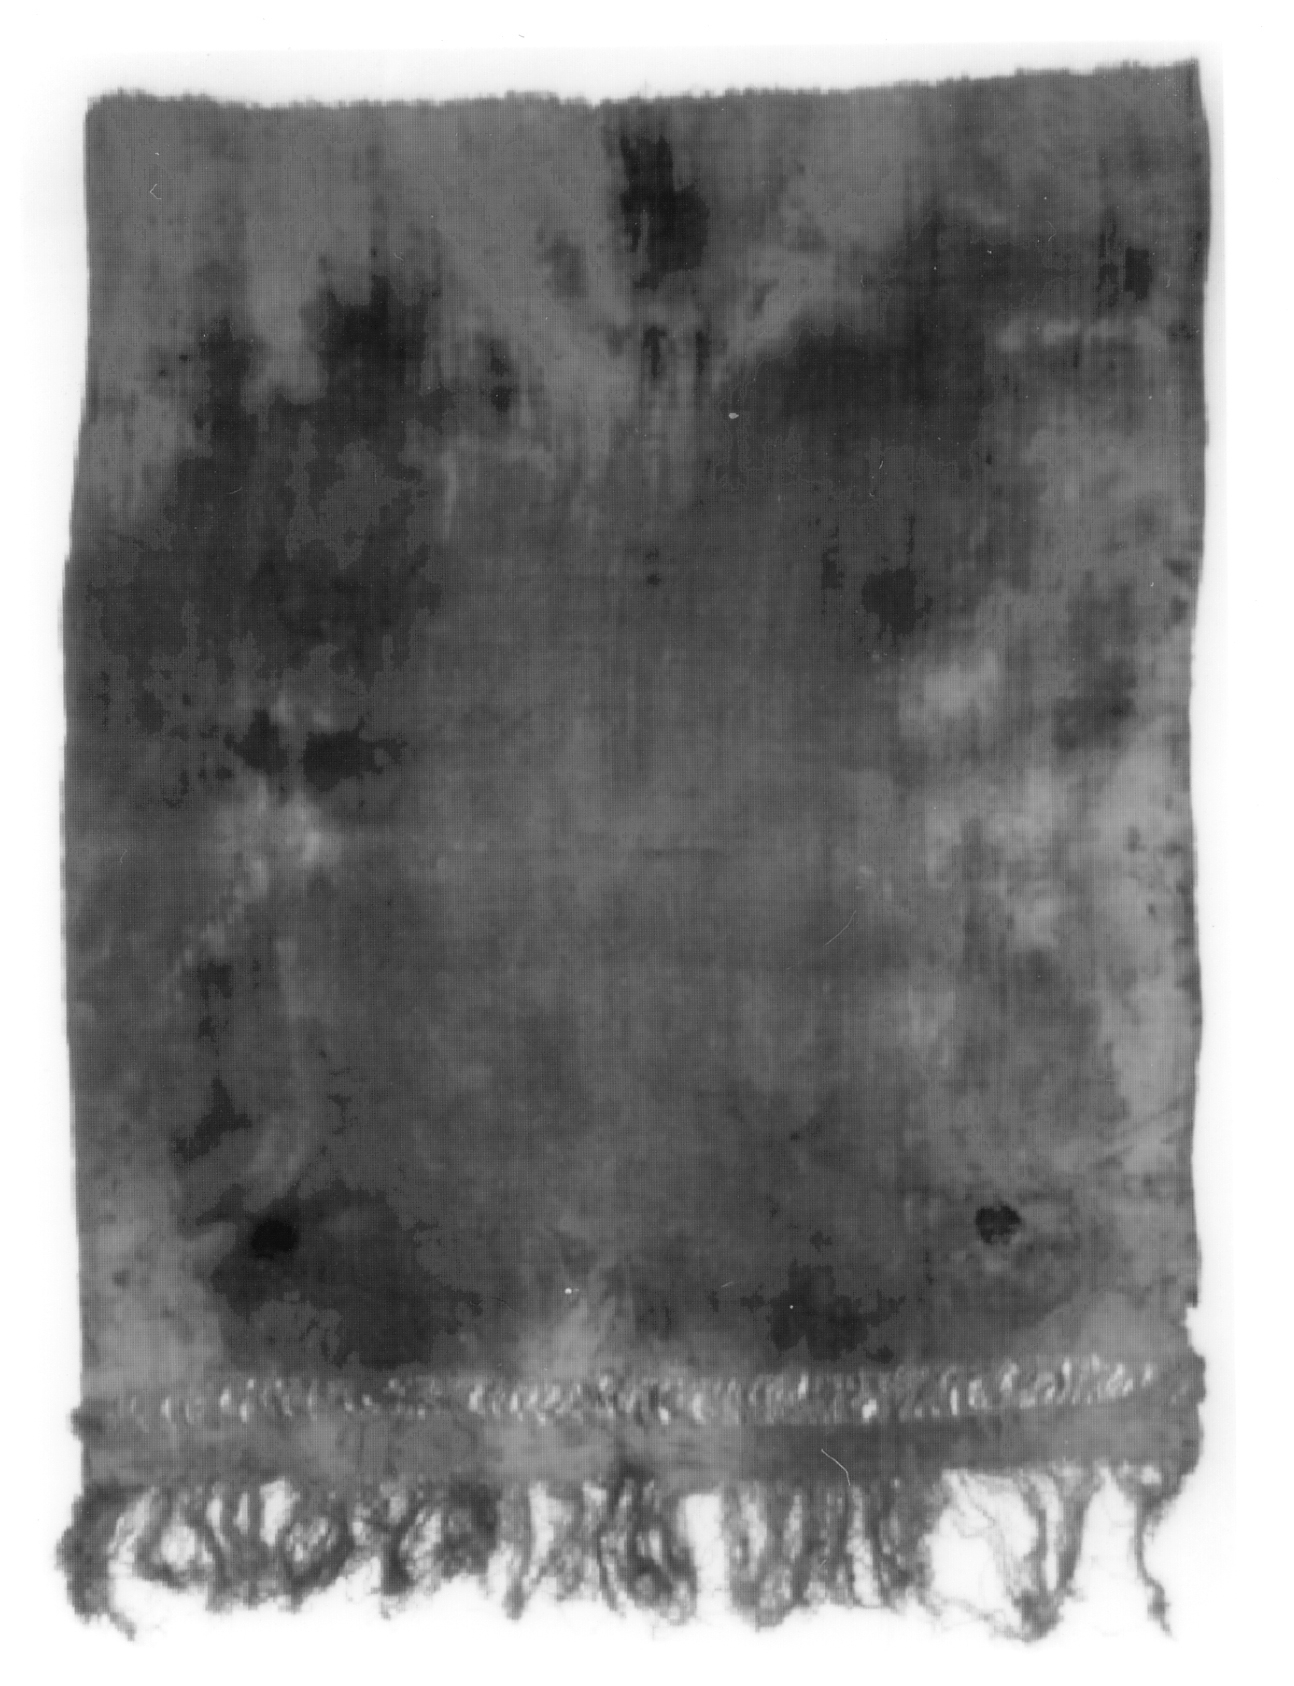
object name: sheet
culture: coptic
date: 301-400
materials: linen, wool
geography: egypt